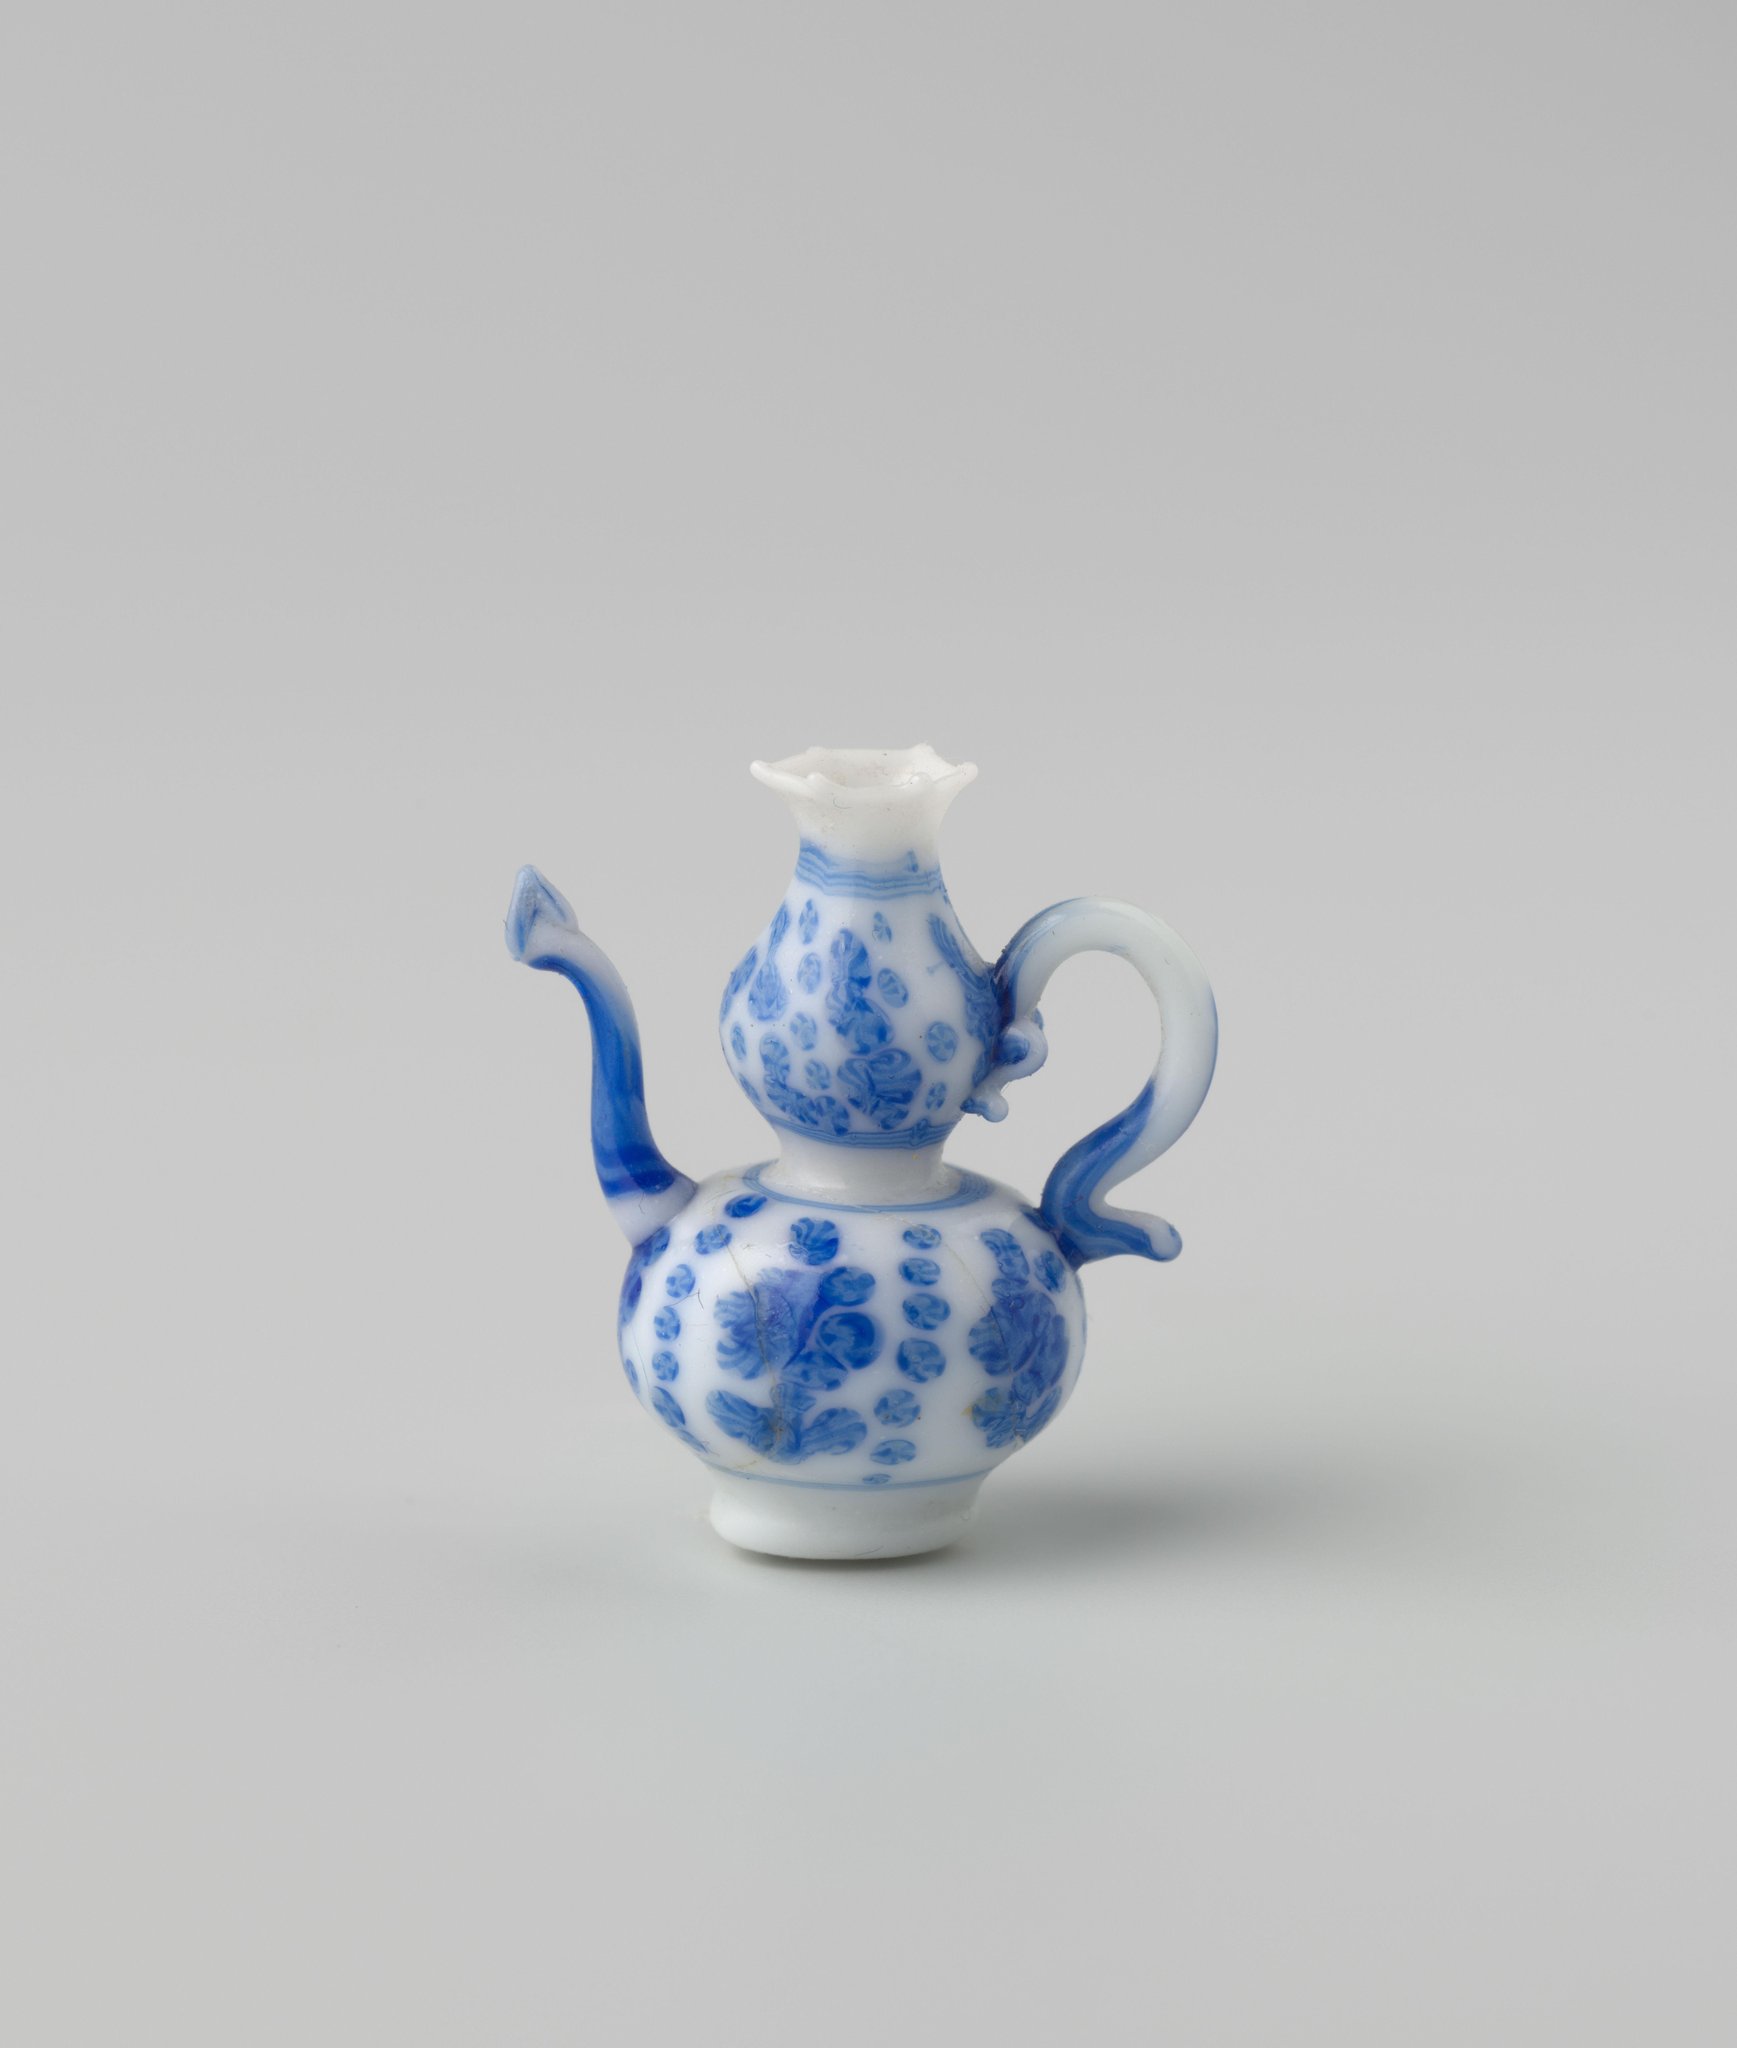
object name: ewer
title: Kan van melkglas met blauwe emailverf beschilderd, imitatie Chinees porselein; bloemen in vakken; model een knobbelfles op standring met tuit en s-vormig handvat.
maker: Anonymous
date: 1675-1710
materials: glass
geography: amsterdam